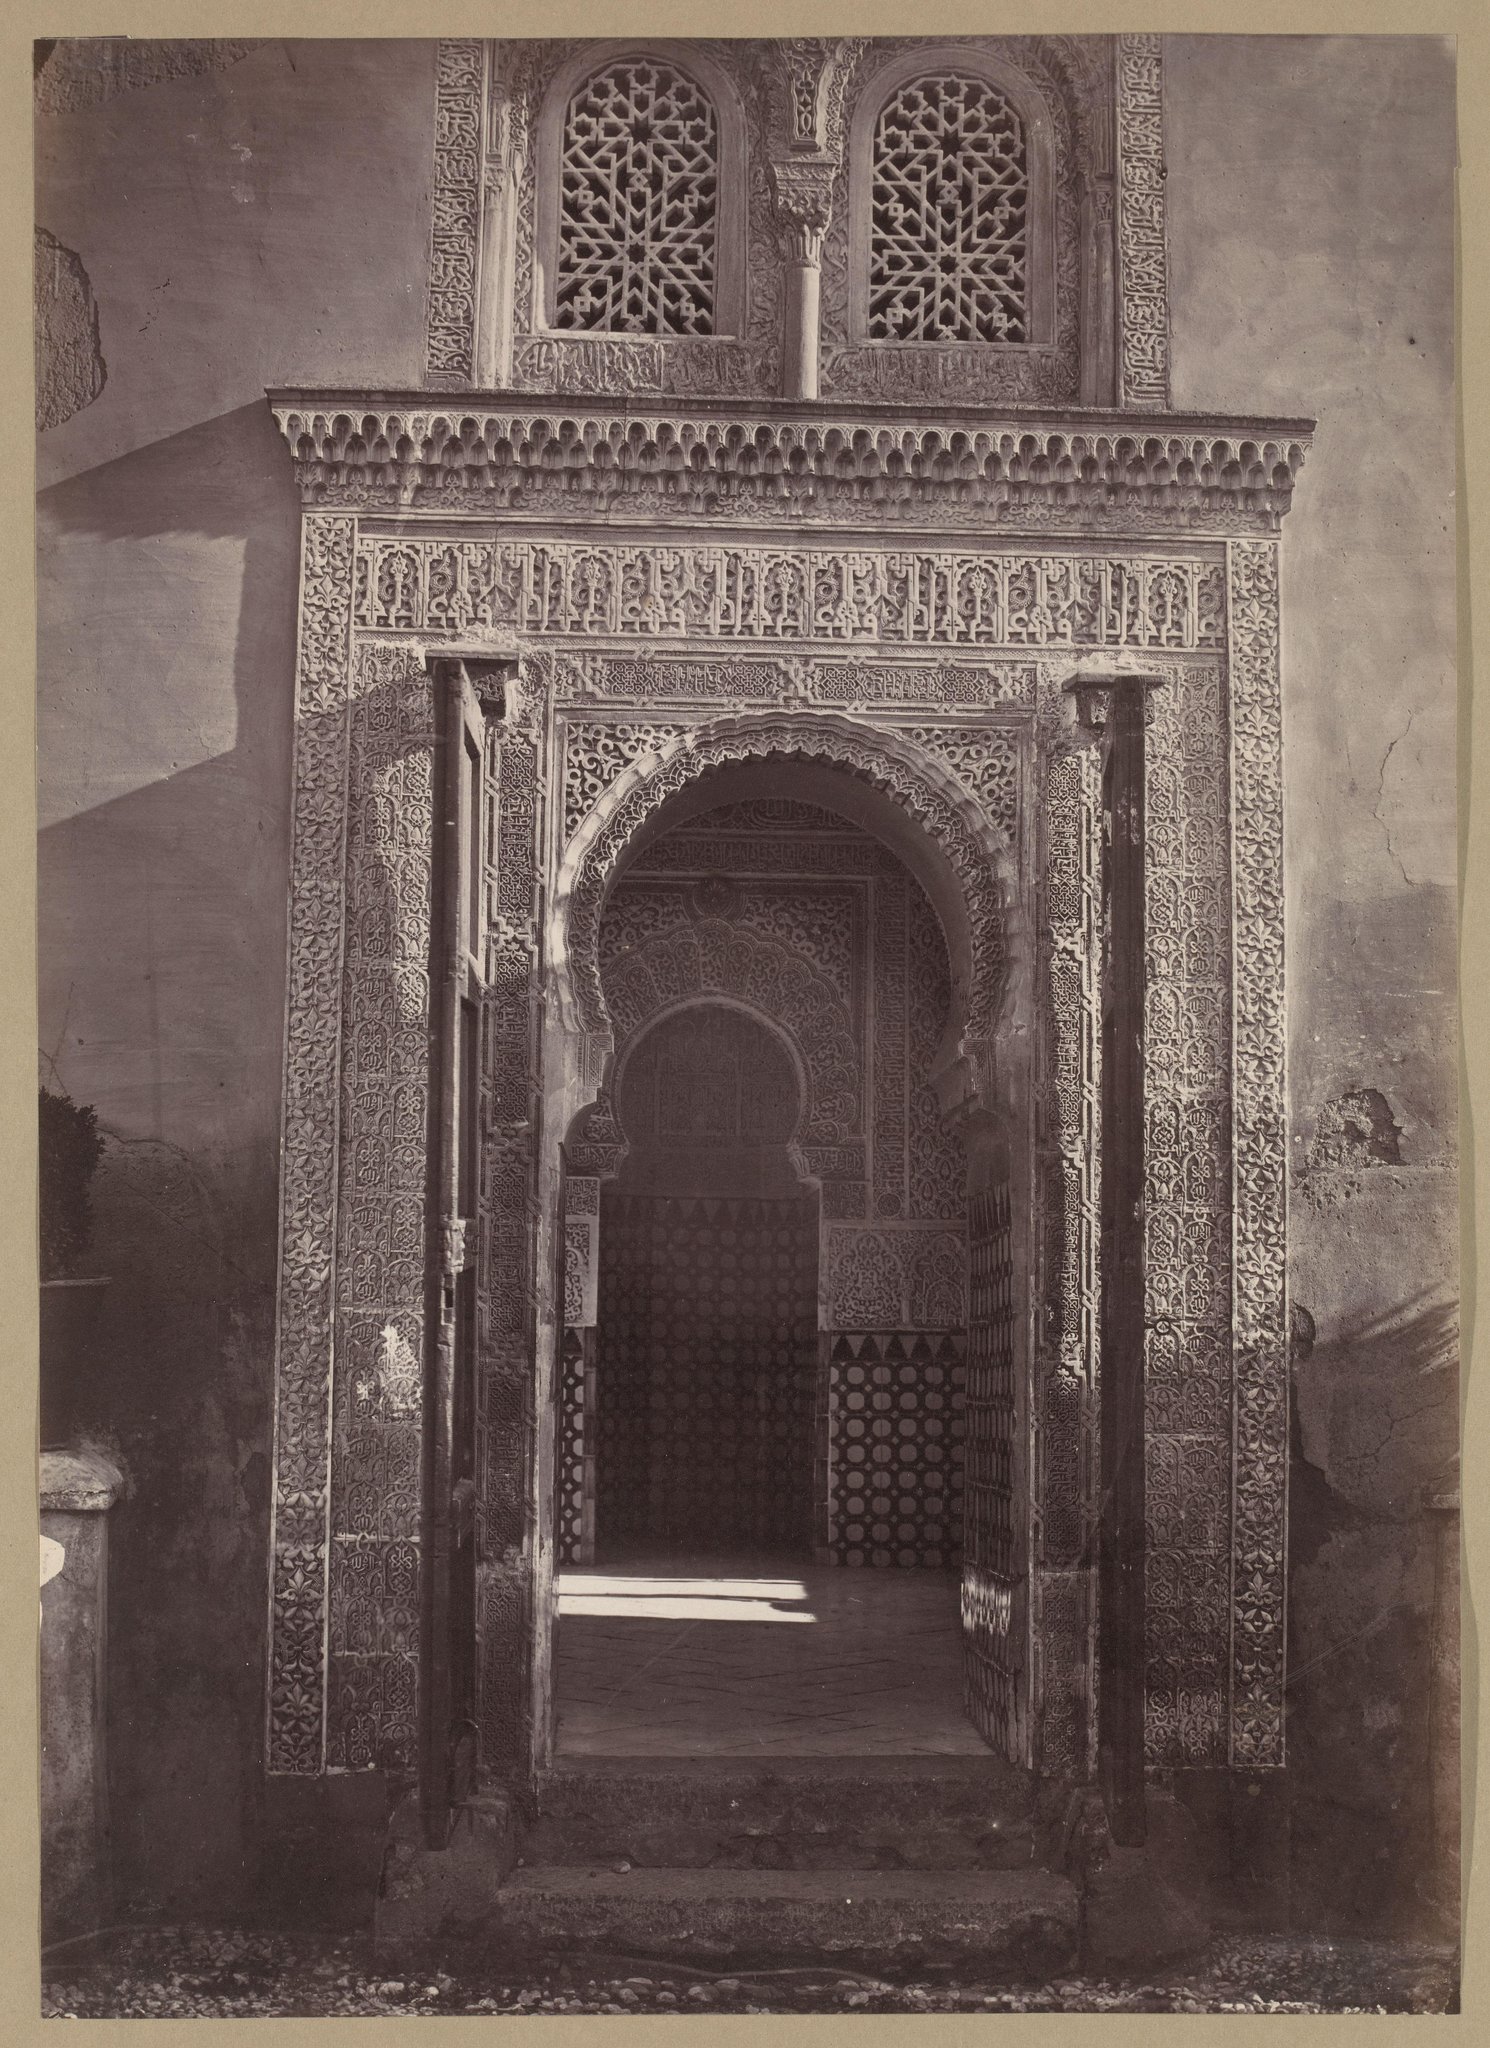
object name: photograph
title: Gezicht op een portaal naar de mihrāb in het Alhambra in Granada, Spanje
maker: Anonymous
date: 1851-1890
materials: paper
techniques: albumen print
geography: granada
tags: temple, shrine ~ islam, mohammedanism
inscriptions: inscription: ‘Alhambra, La Mezquita/ Granada’